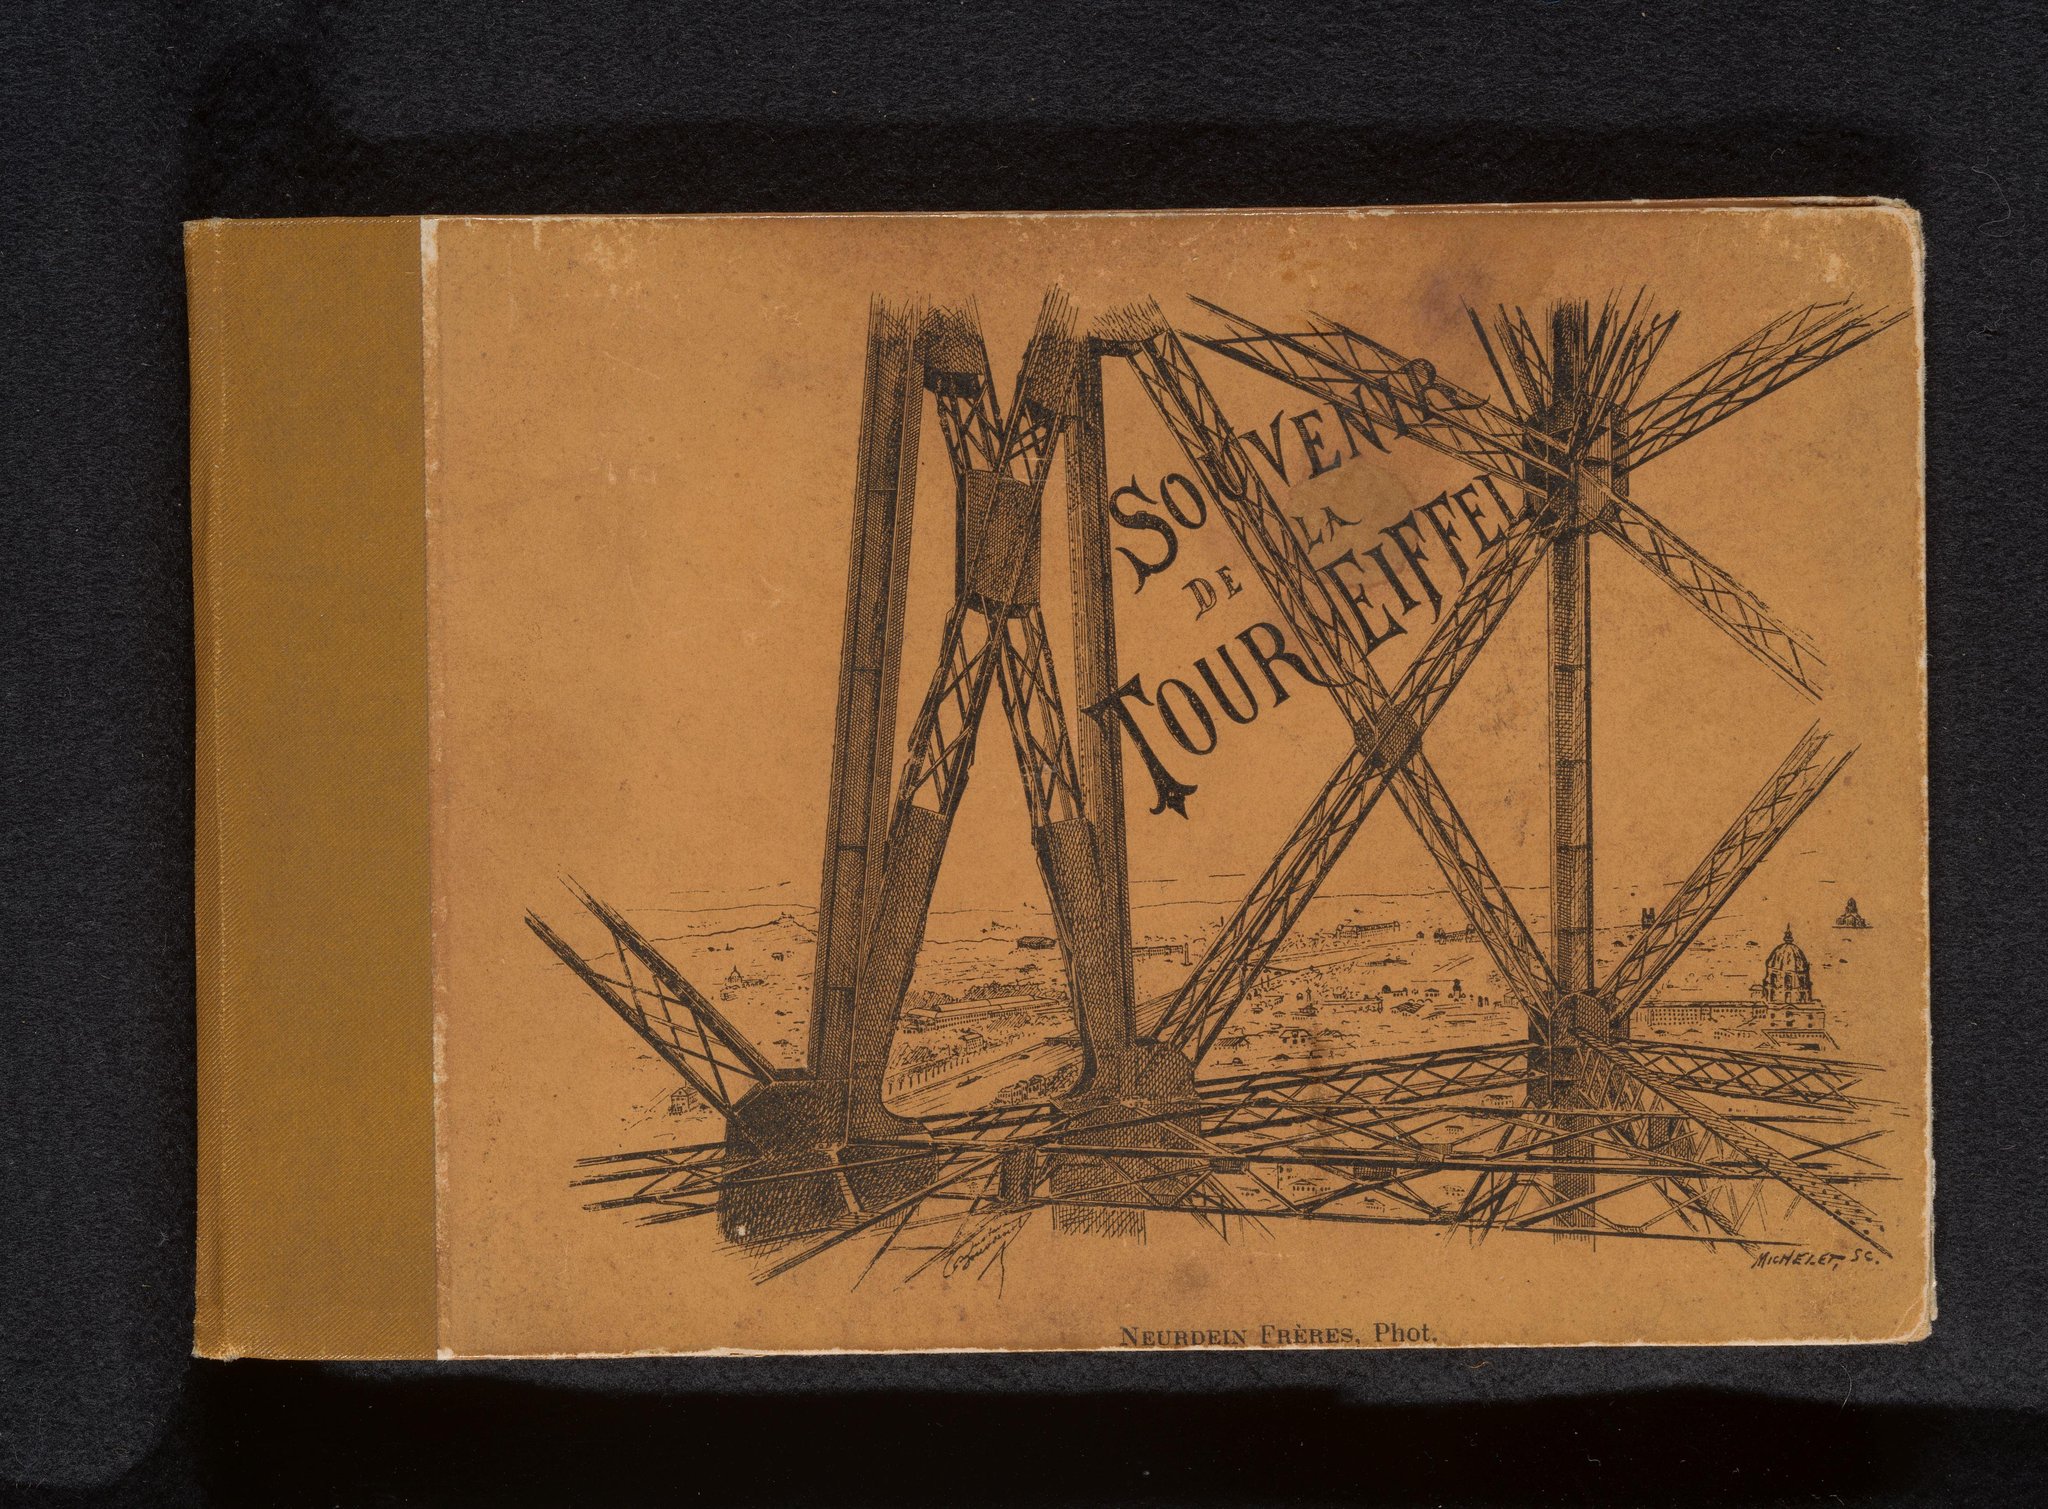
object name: book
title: Souvenir de la Tour Eiffel : [exposition universelle de 1889]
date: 1889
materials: cardboard, paper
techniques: photograph, printing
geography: paris